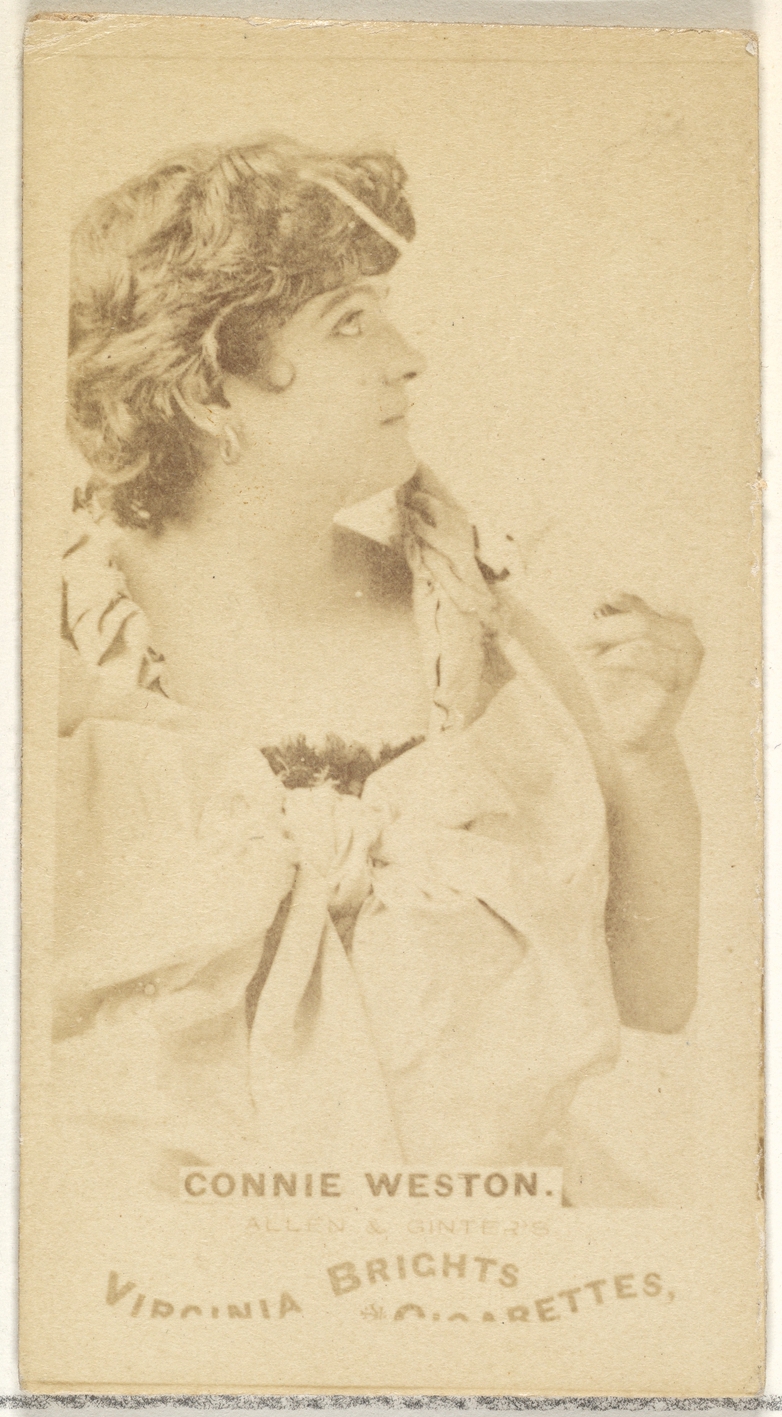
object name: photograph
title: Connie Weston, from the Actors and Actresses series (N45, Type 1) for Virginia Brights Cigarettes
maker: allen & ginter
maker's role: publisher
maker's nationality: american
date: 1888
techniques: albumen silver print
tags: portraits,women,actresses